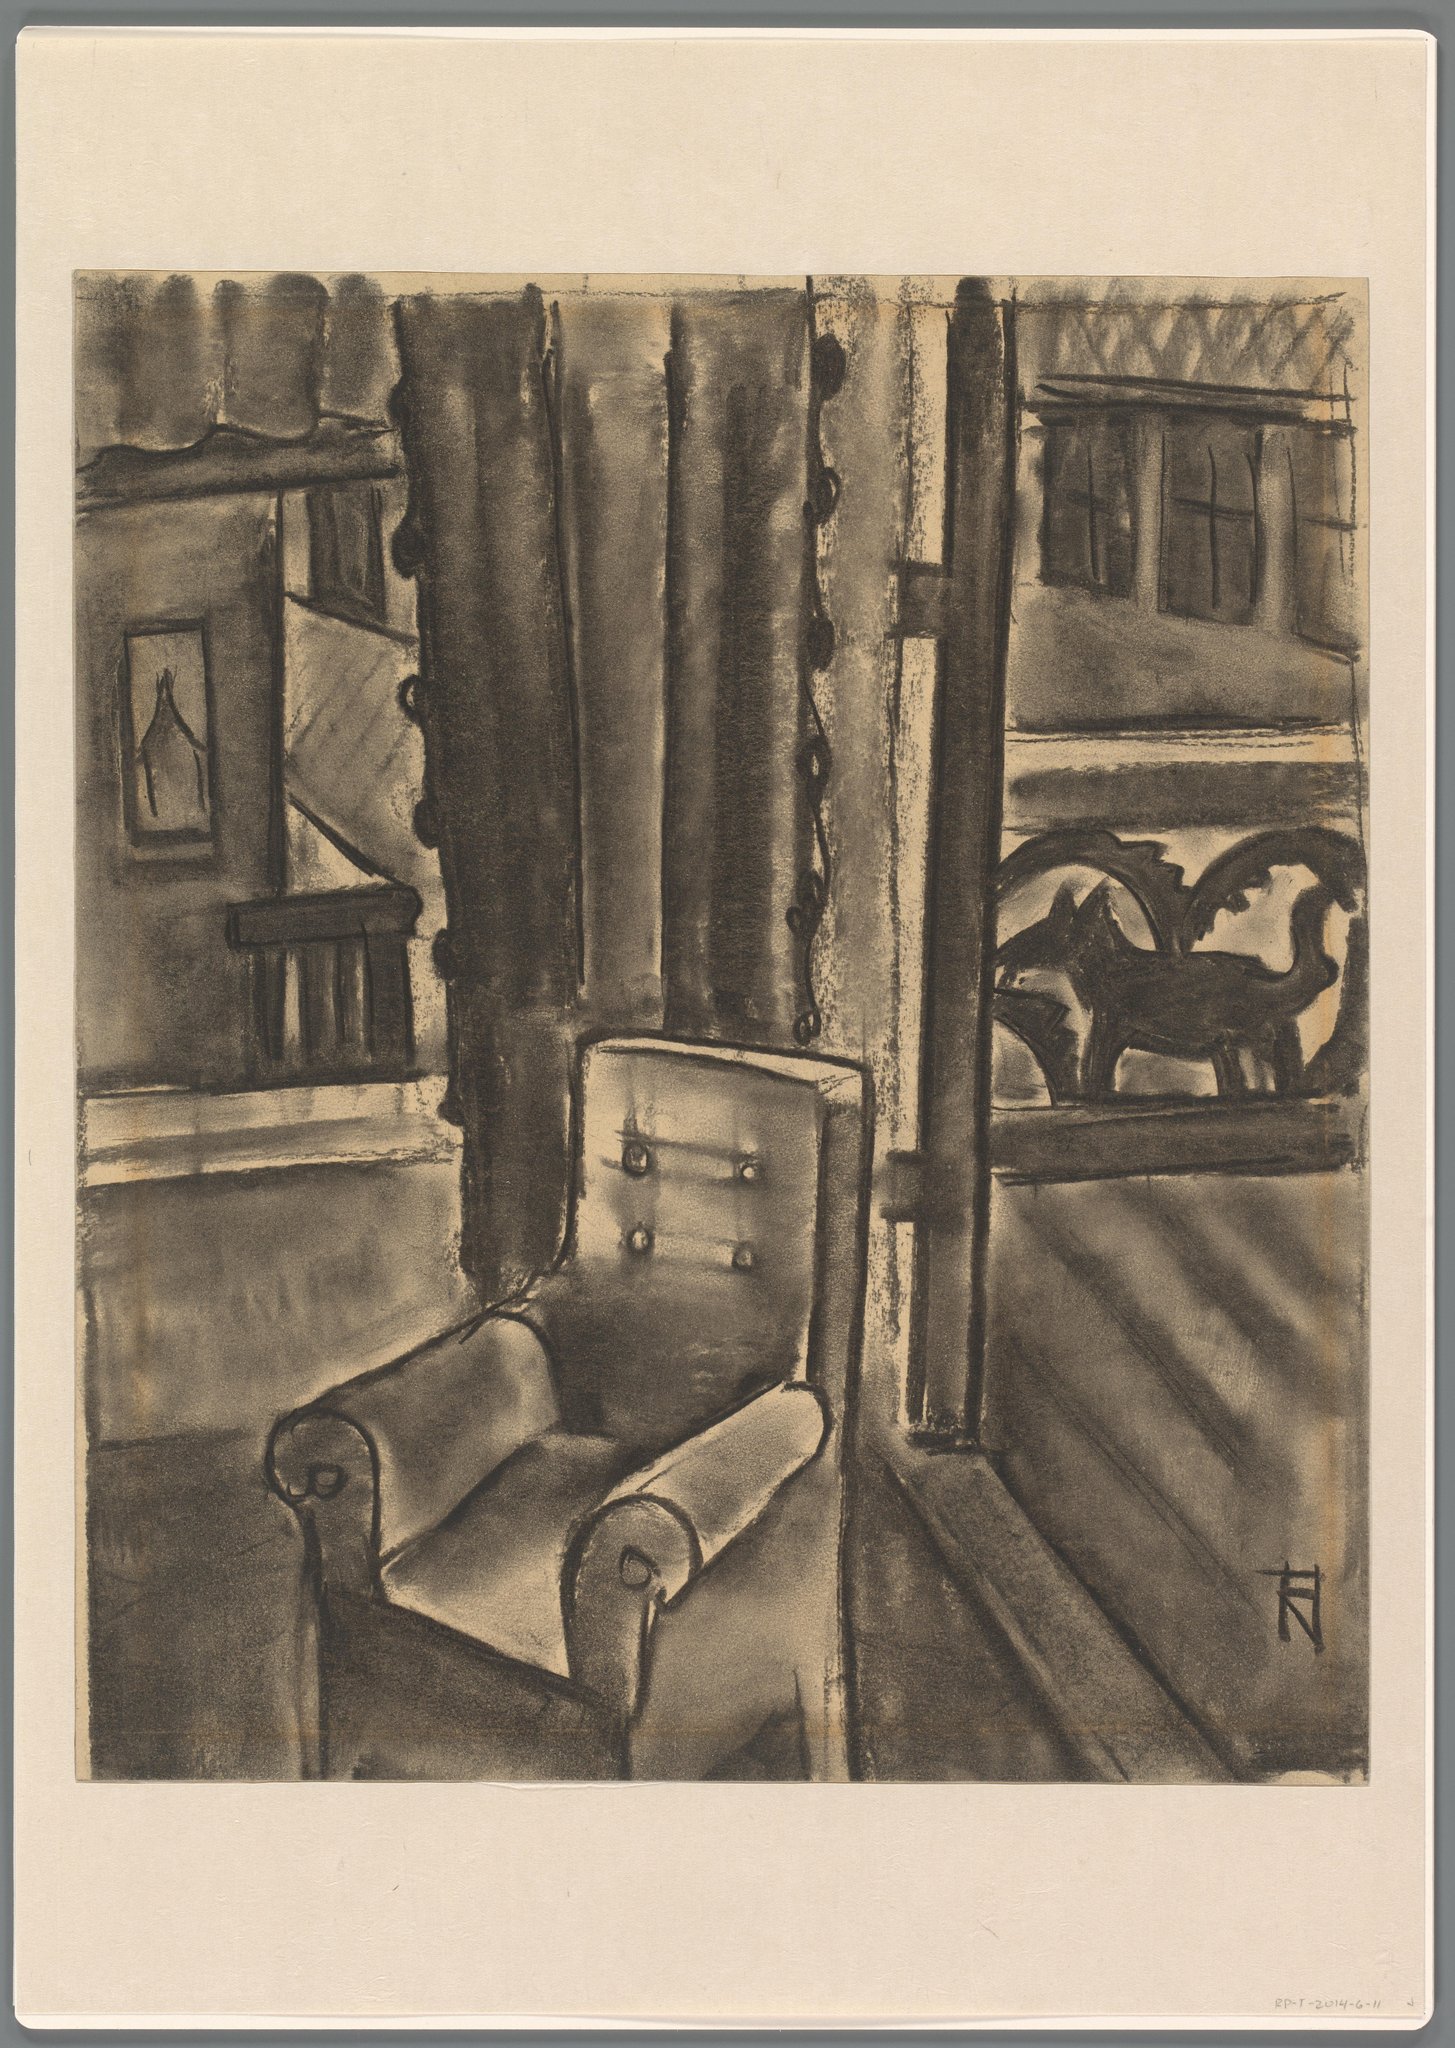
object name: drawing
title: Stoel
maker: bob hanf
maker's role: draughtsman, print maker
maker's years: 1894-1944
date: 1920-1923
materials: charcoal, paper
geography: netherlands